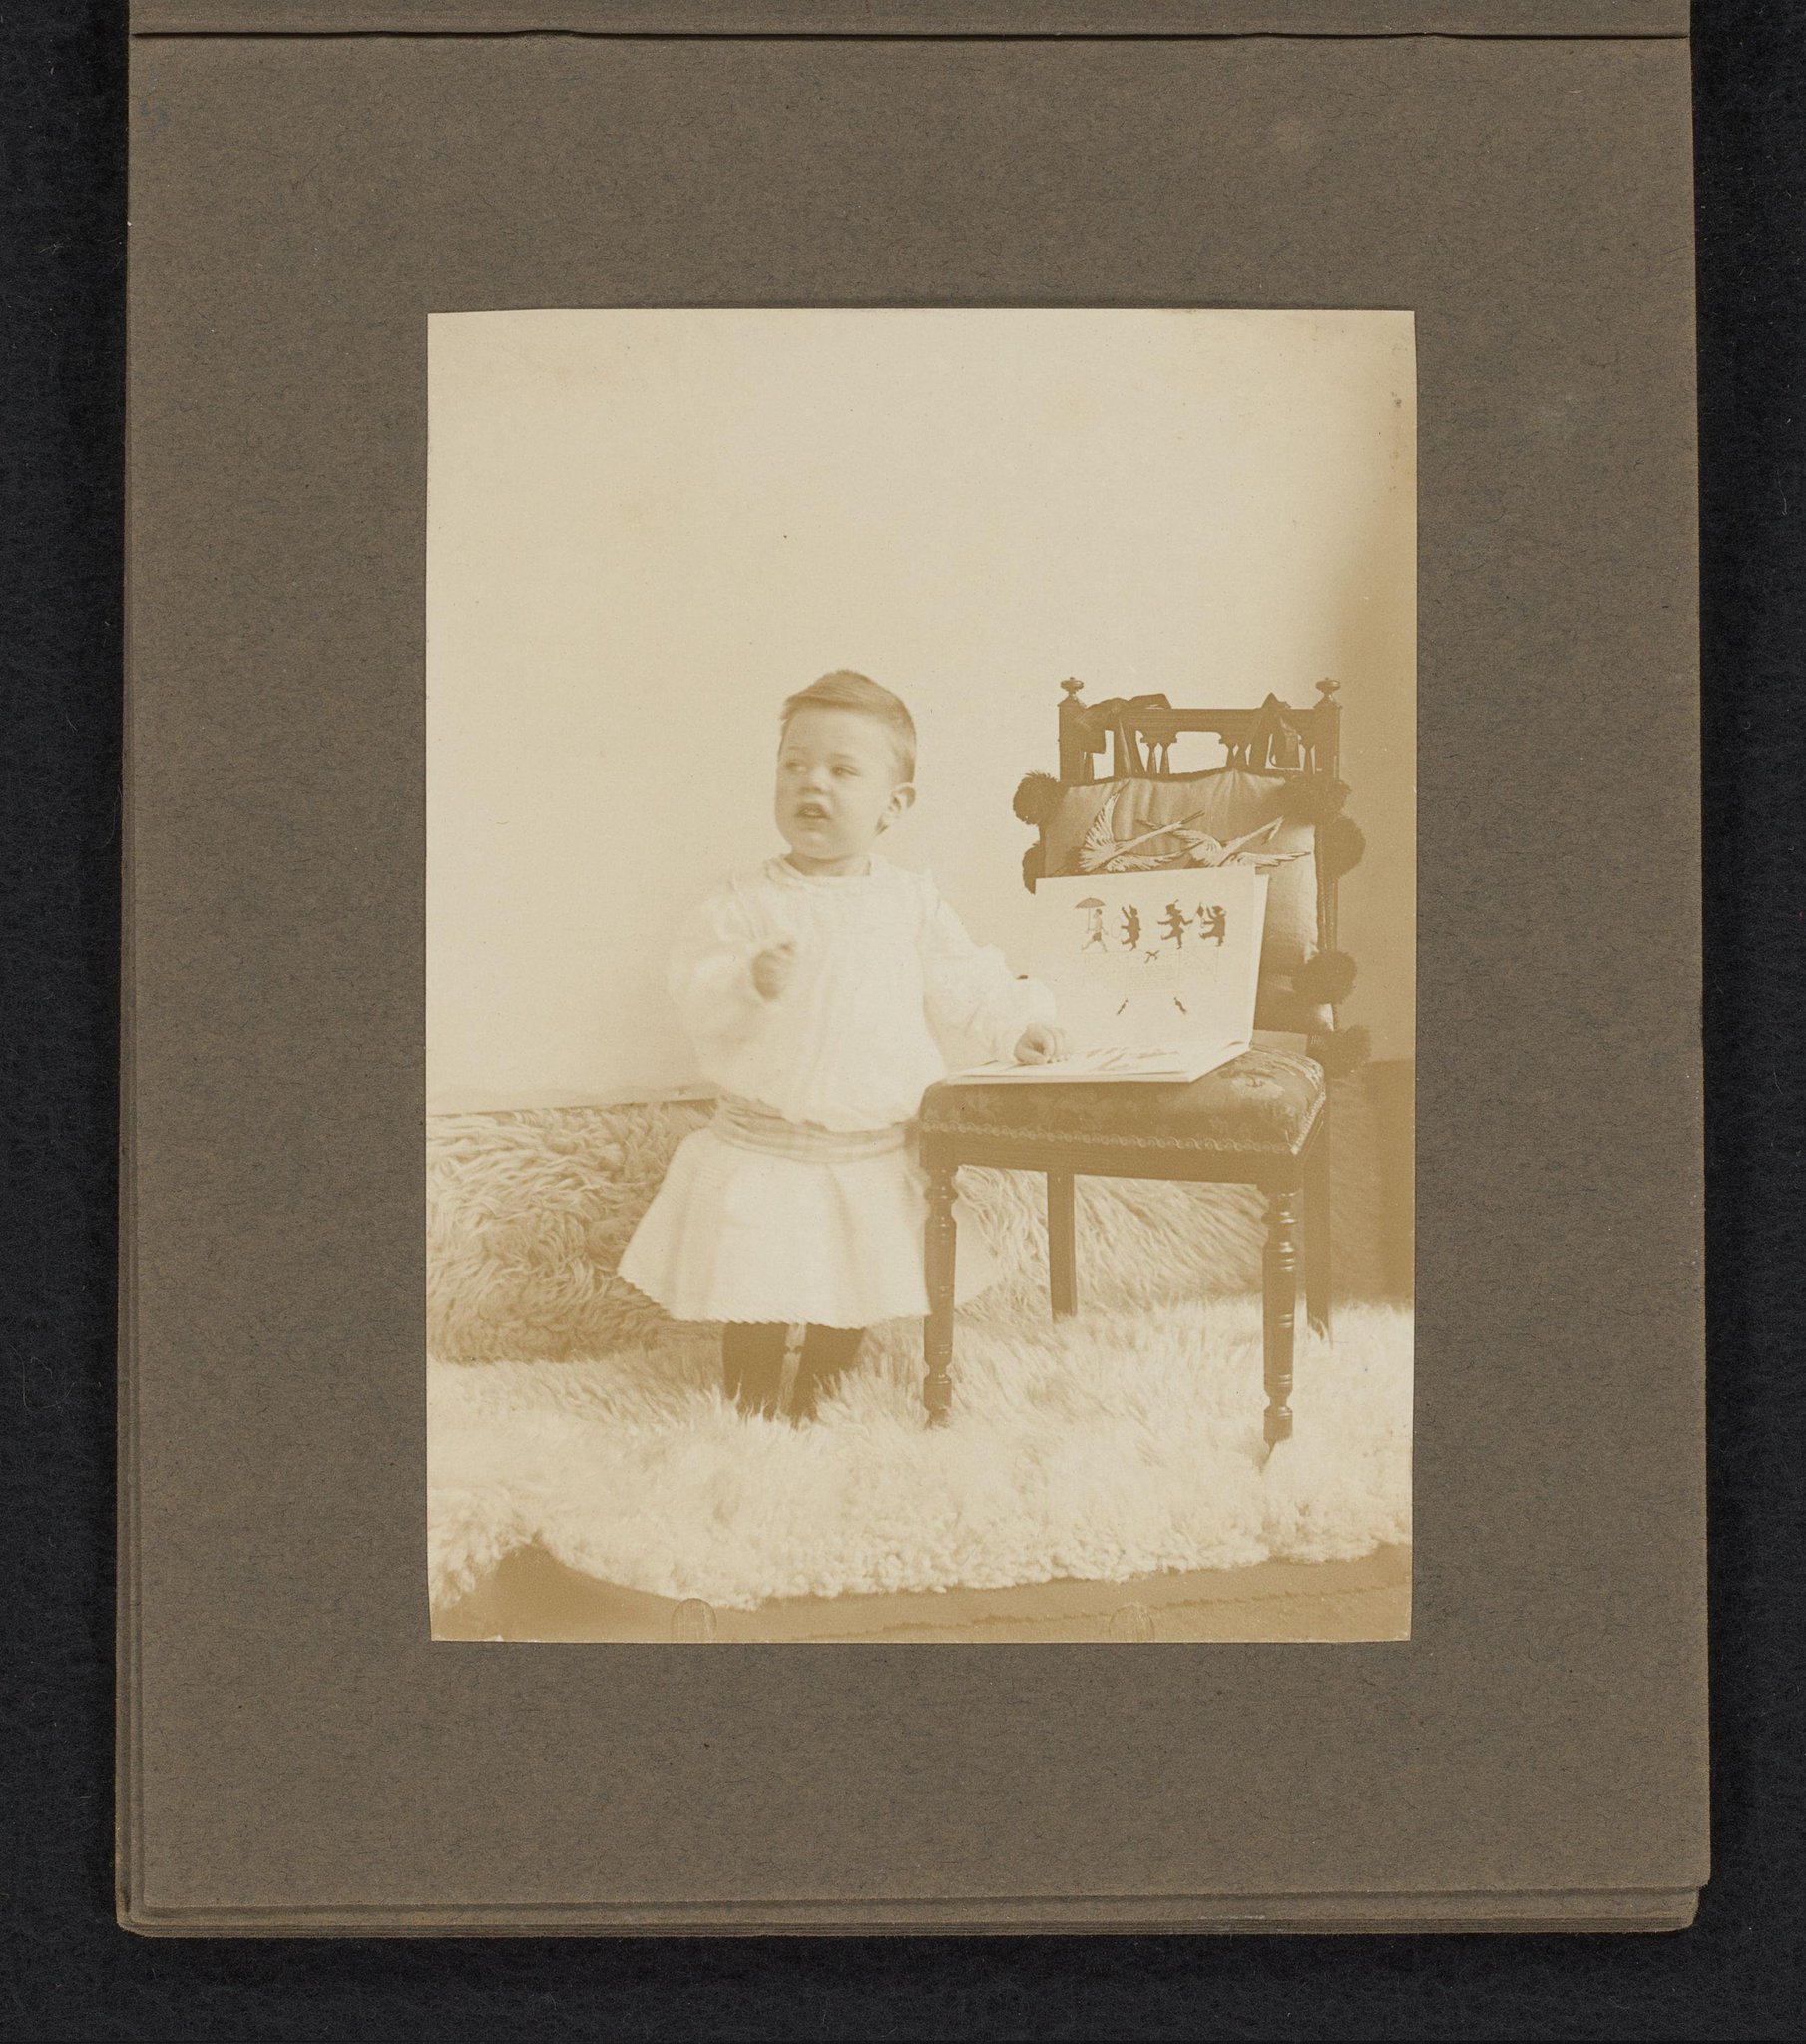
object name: album leaf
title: Carel van den Berg bij een prentenboek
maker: hendrik herman van den berg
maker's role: amateurfotograaf, jurist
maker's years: 1875-1944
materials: paper, cardboard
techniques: gelatin silver print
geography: amsterdam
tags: carel frederik van den berg (cay), toddler (male)